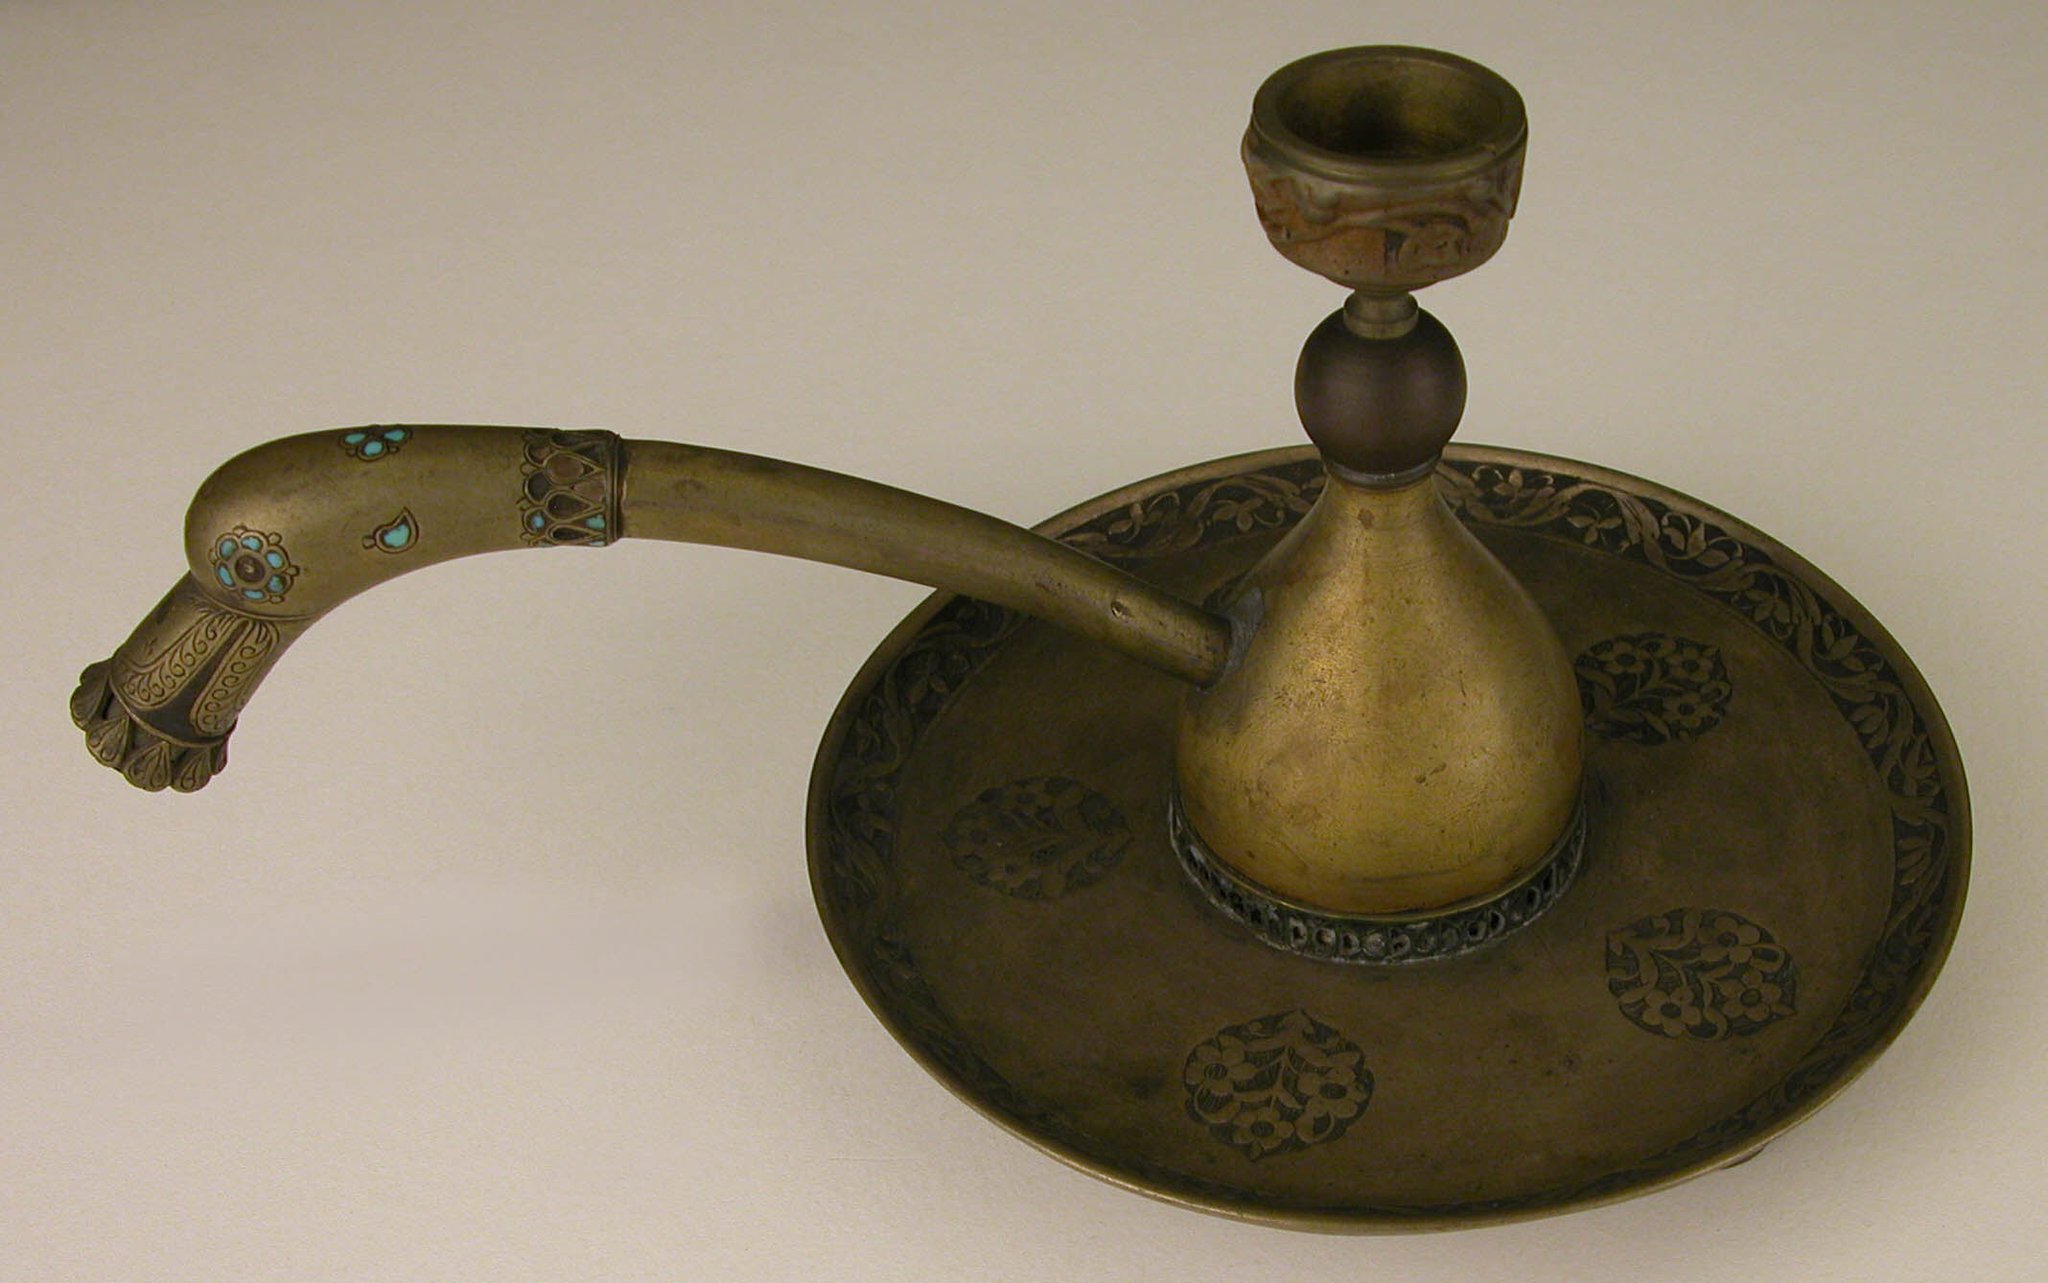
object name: water pipe part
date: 1701-1900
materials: brass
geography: iran